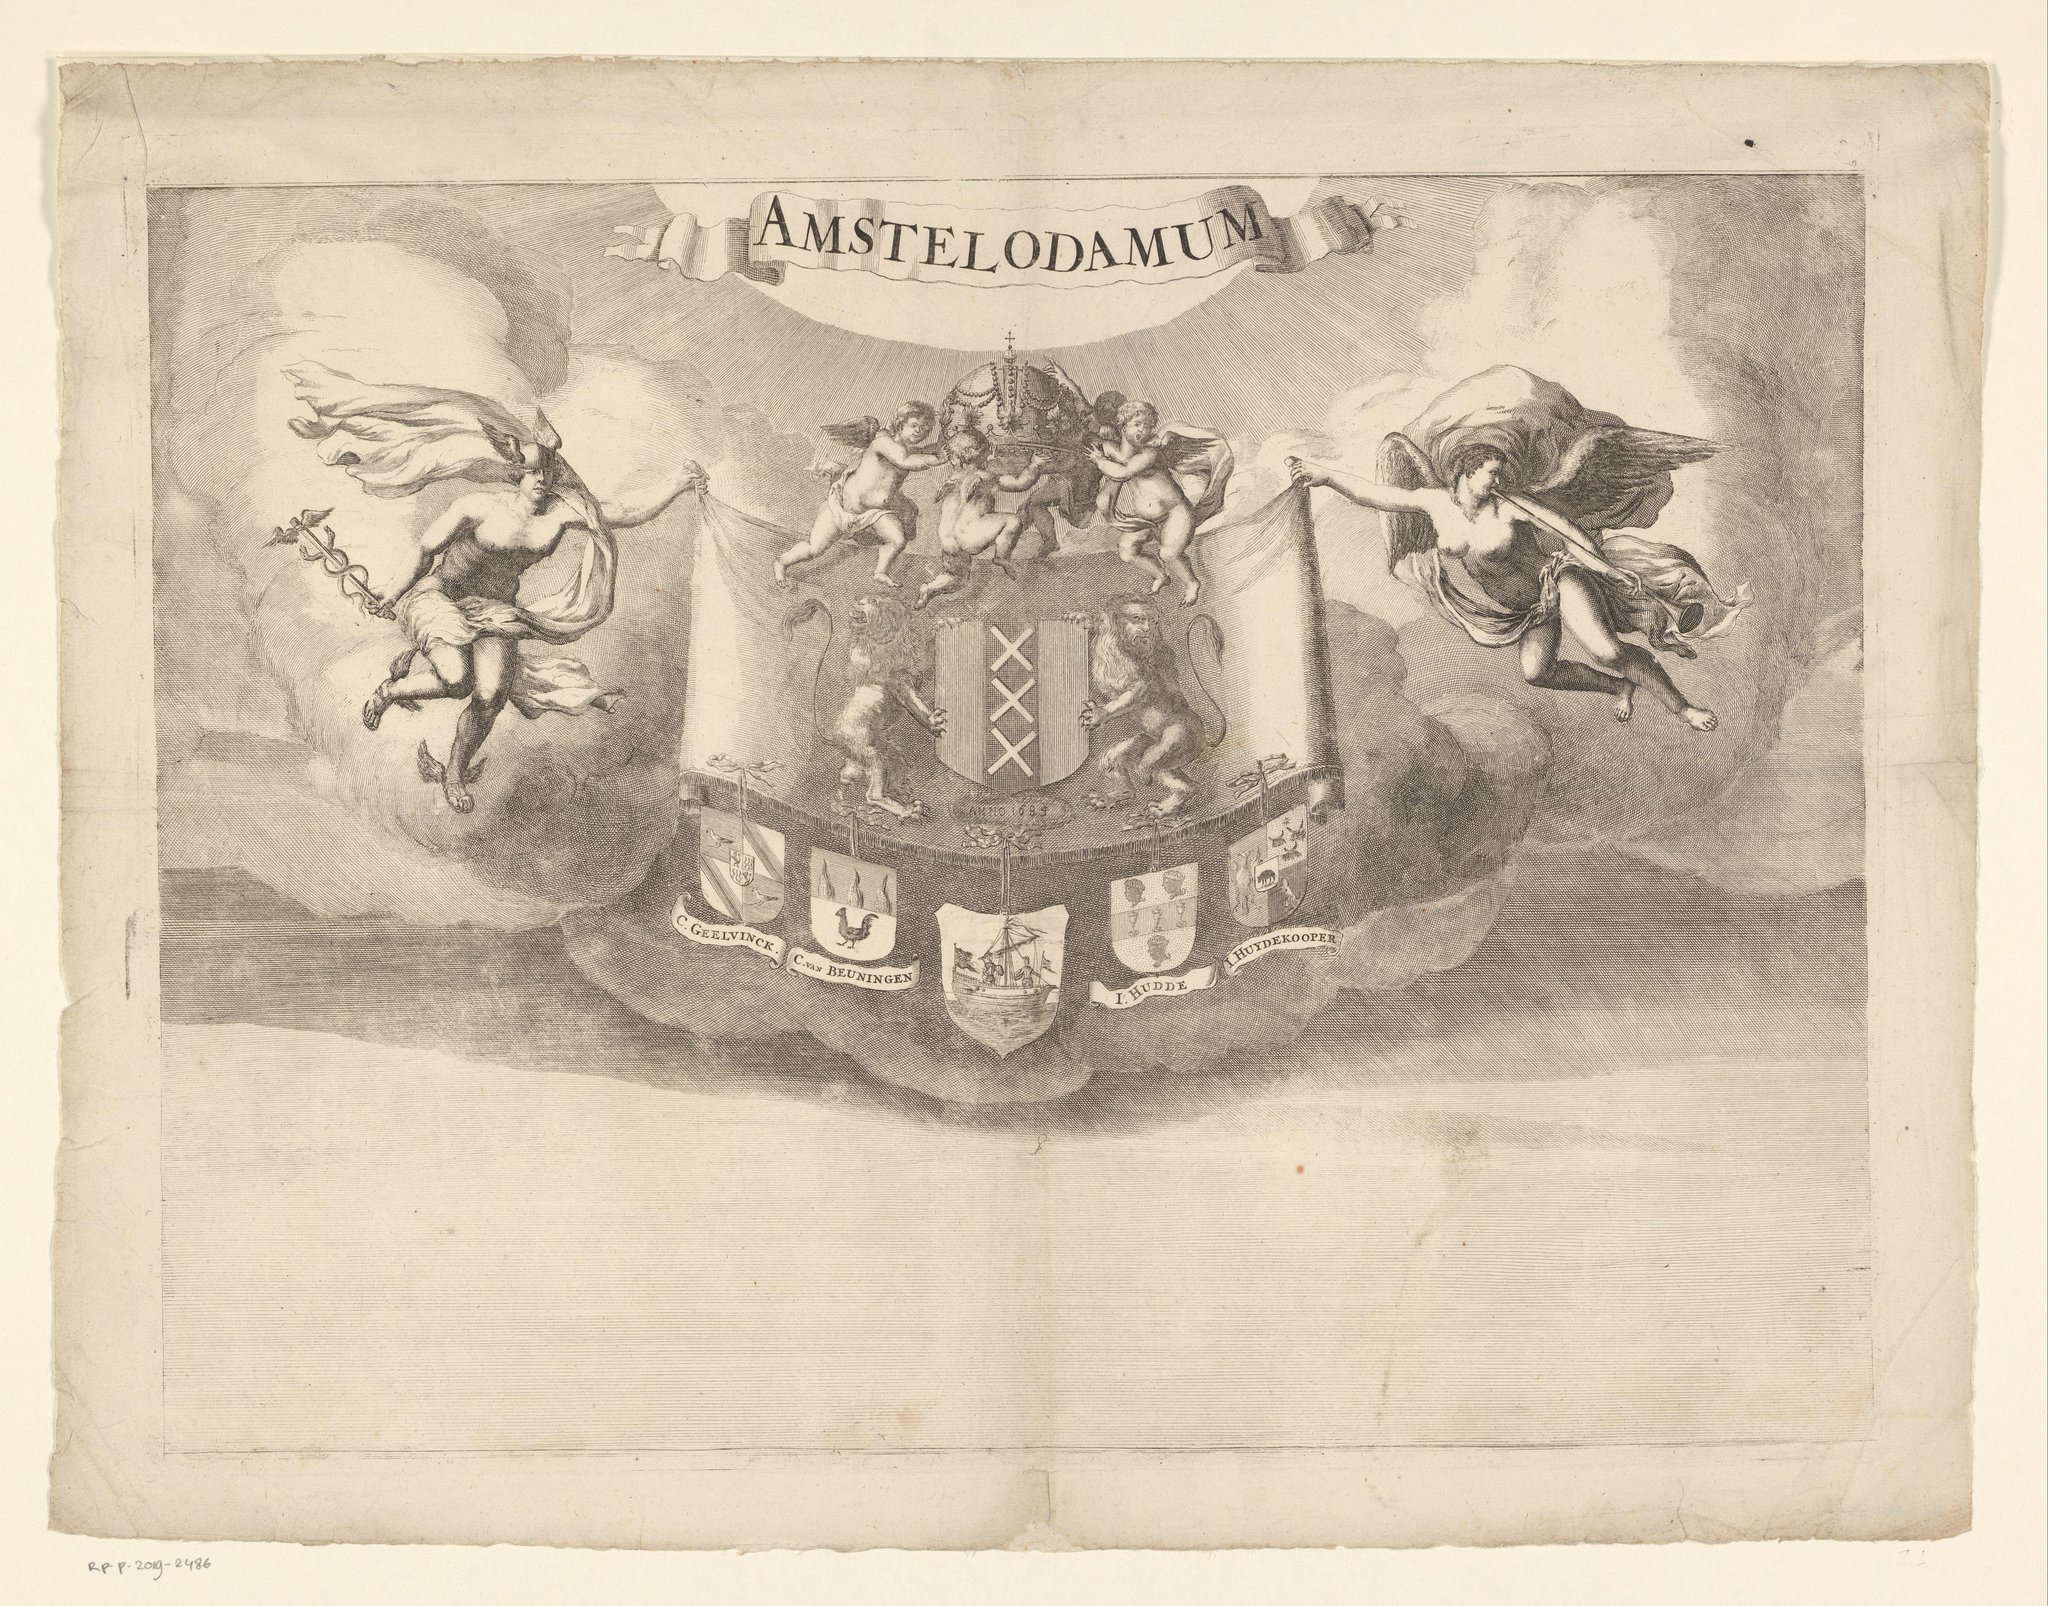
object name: print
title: Wapen van Amsterdam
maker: Anonymous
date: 1684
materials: paper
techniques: etching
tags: coat of arms (as symbol of the state, etc.), specific aspects, allegorical aspects of mercury; mercury as patron, amsterdam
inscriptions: date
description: Wapen van Amsterdam vastgehouden door Mercurius en Faam. Onder het stadswapen hangen vier familiewapens (G. Geelvinck, C. van Beuningen, J. Hudde en J. Huydecoper) en een wapenschild met daarop een schip.